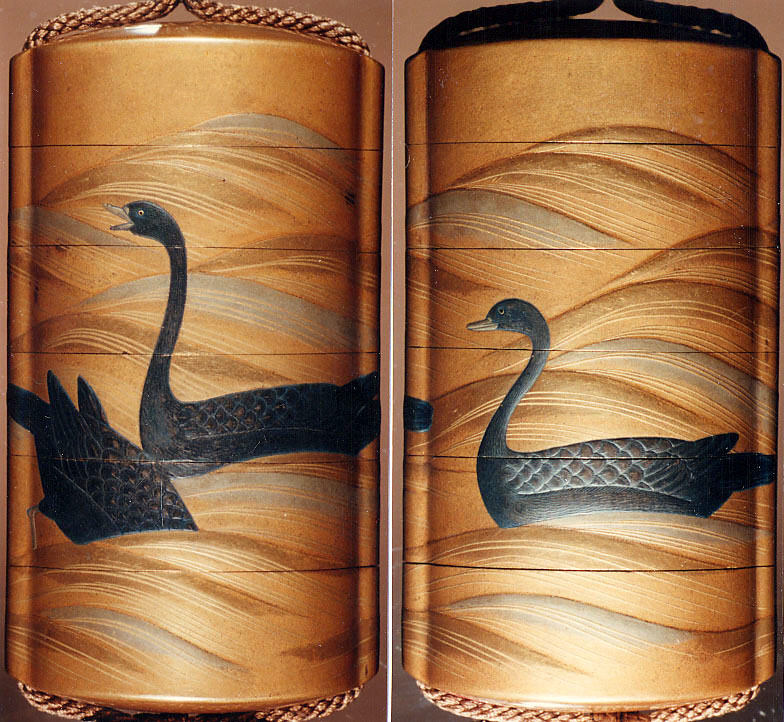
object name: inrō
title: Case (Inrō) with Design of Three Geese Swimming and Diving on Waves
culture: japanese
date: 1801-1900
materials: gold, lacquer, silver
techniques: fundame, hiramakie, maki-e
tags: birds,waves